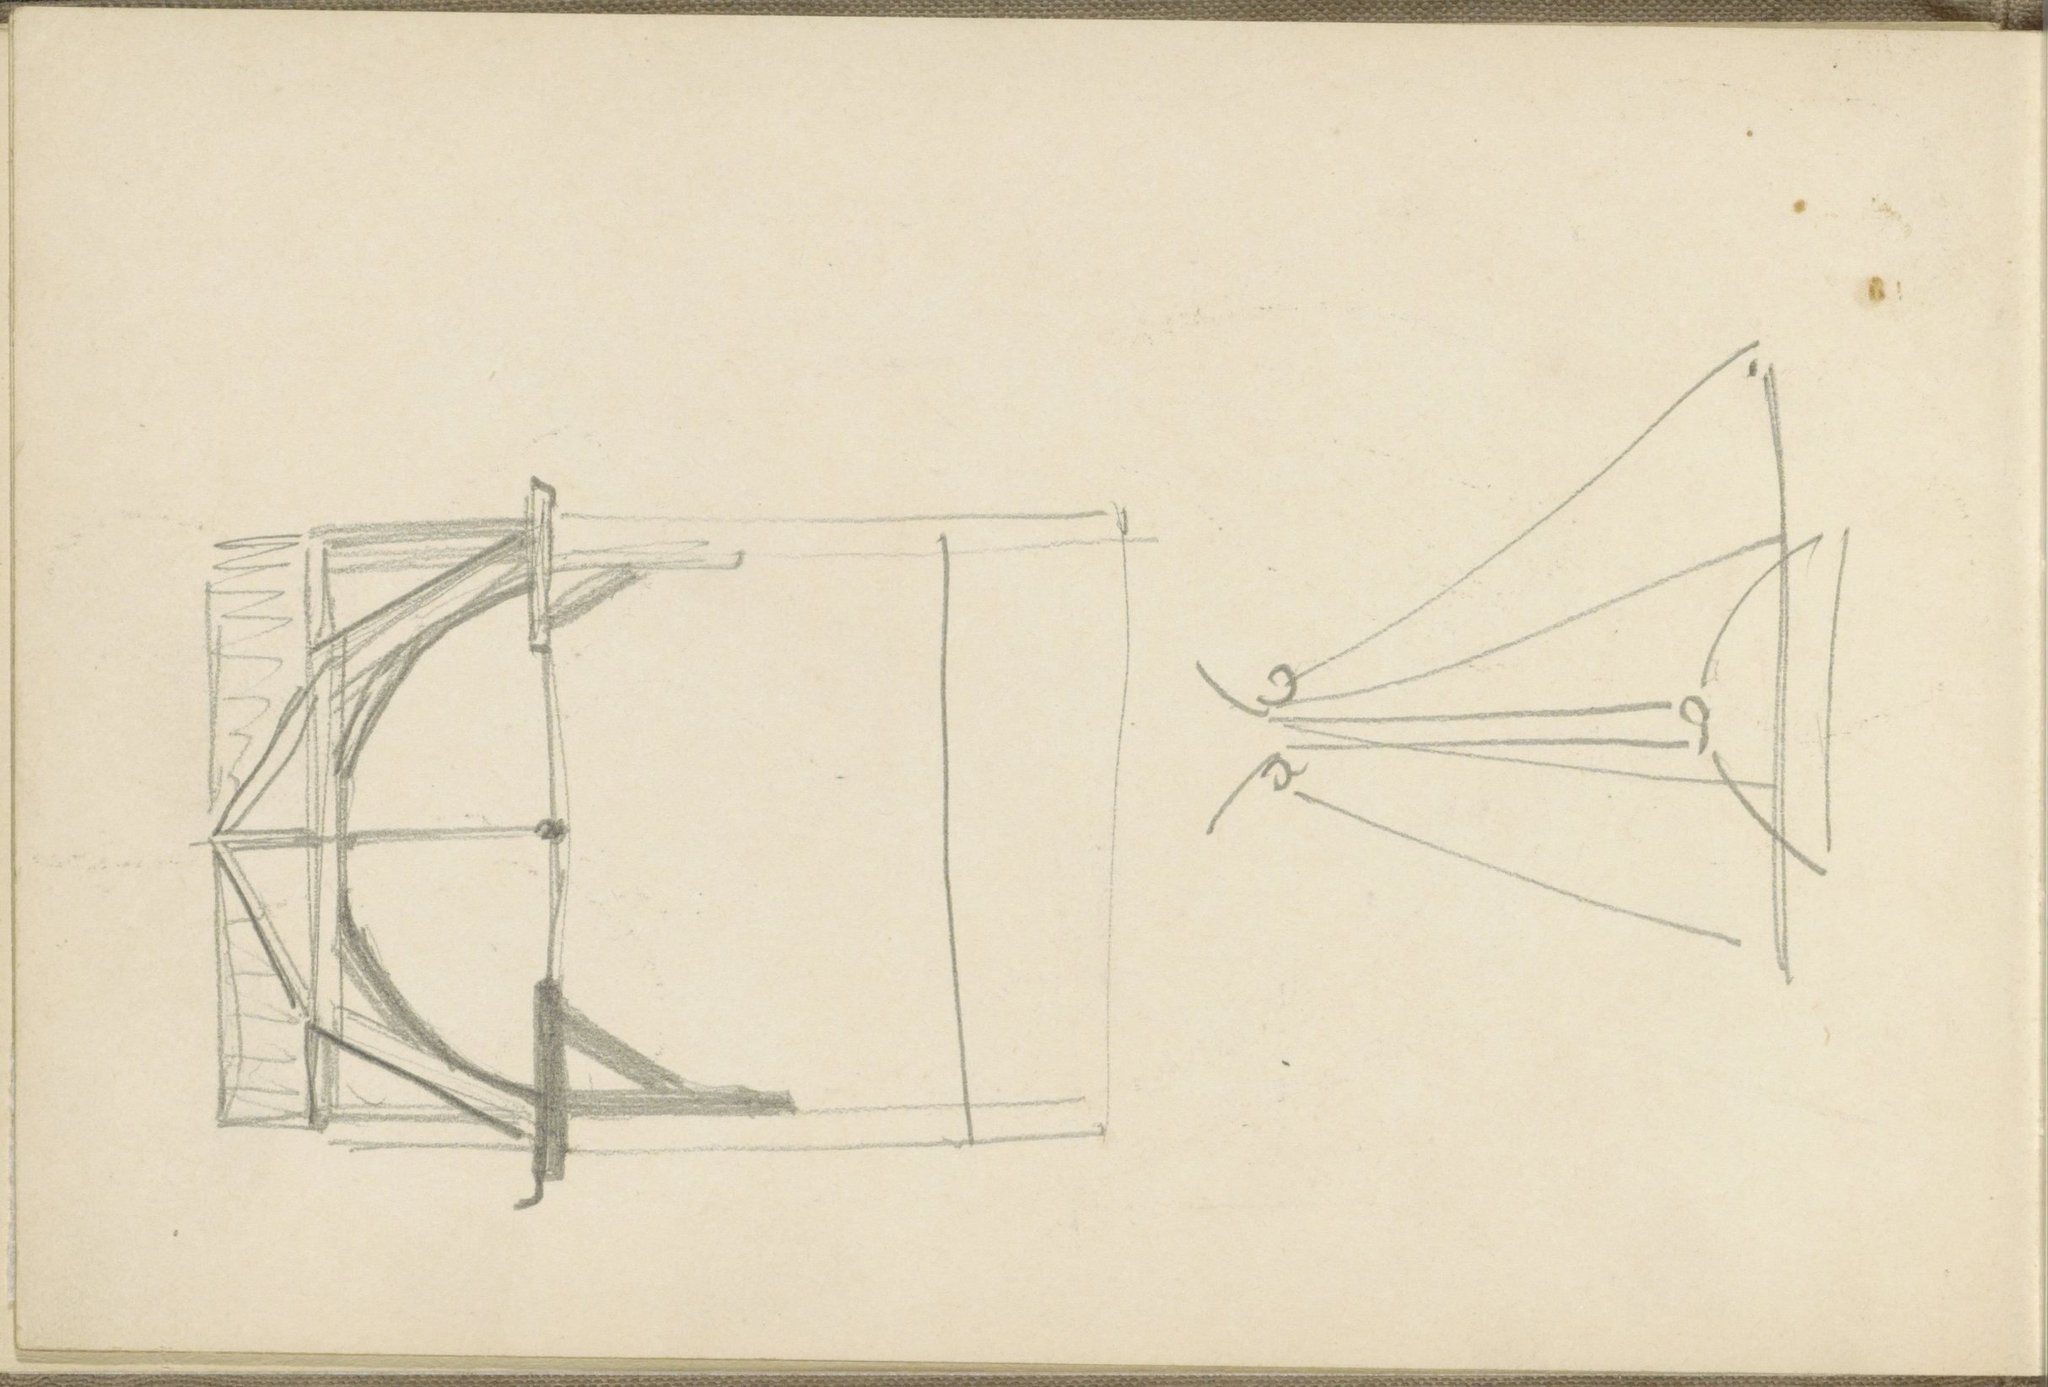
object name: sketchbook leaf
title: Gewelf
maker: carel adolph lion cachet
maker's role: draughtsman, print maker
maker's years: 1864-1945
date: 1905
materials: paper, pencil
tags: vault ~ architecture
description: Blad 18 verso uit een schetsboek met 27 bladen.